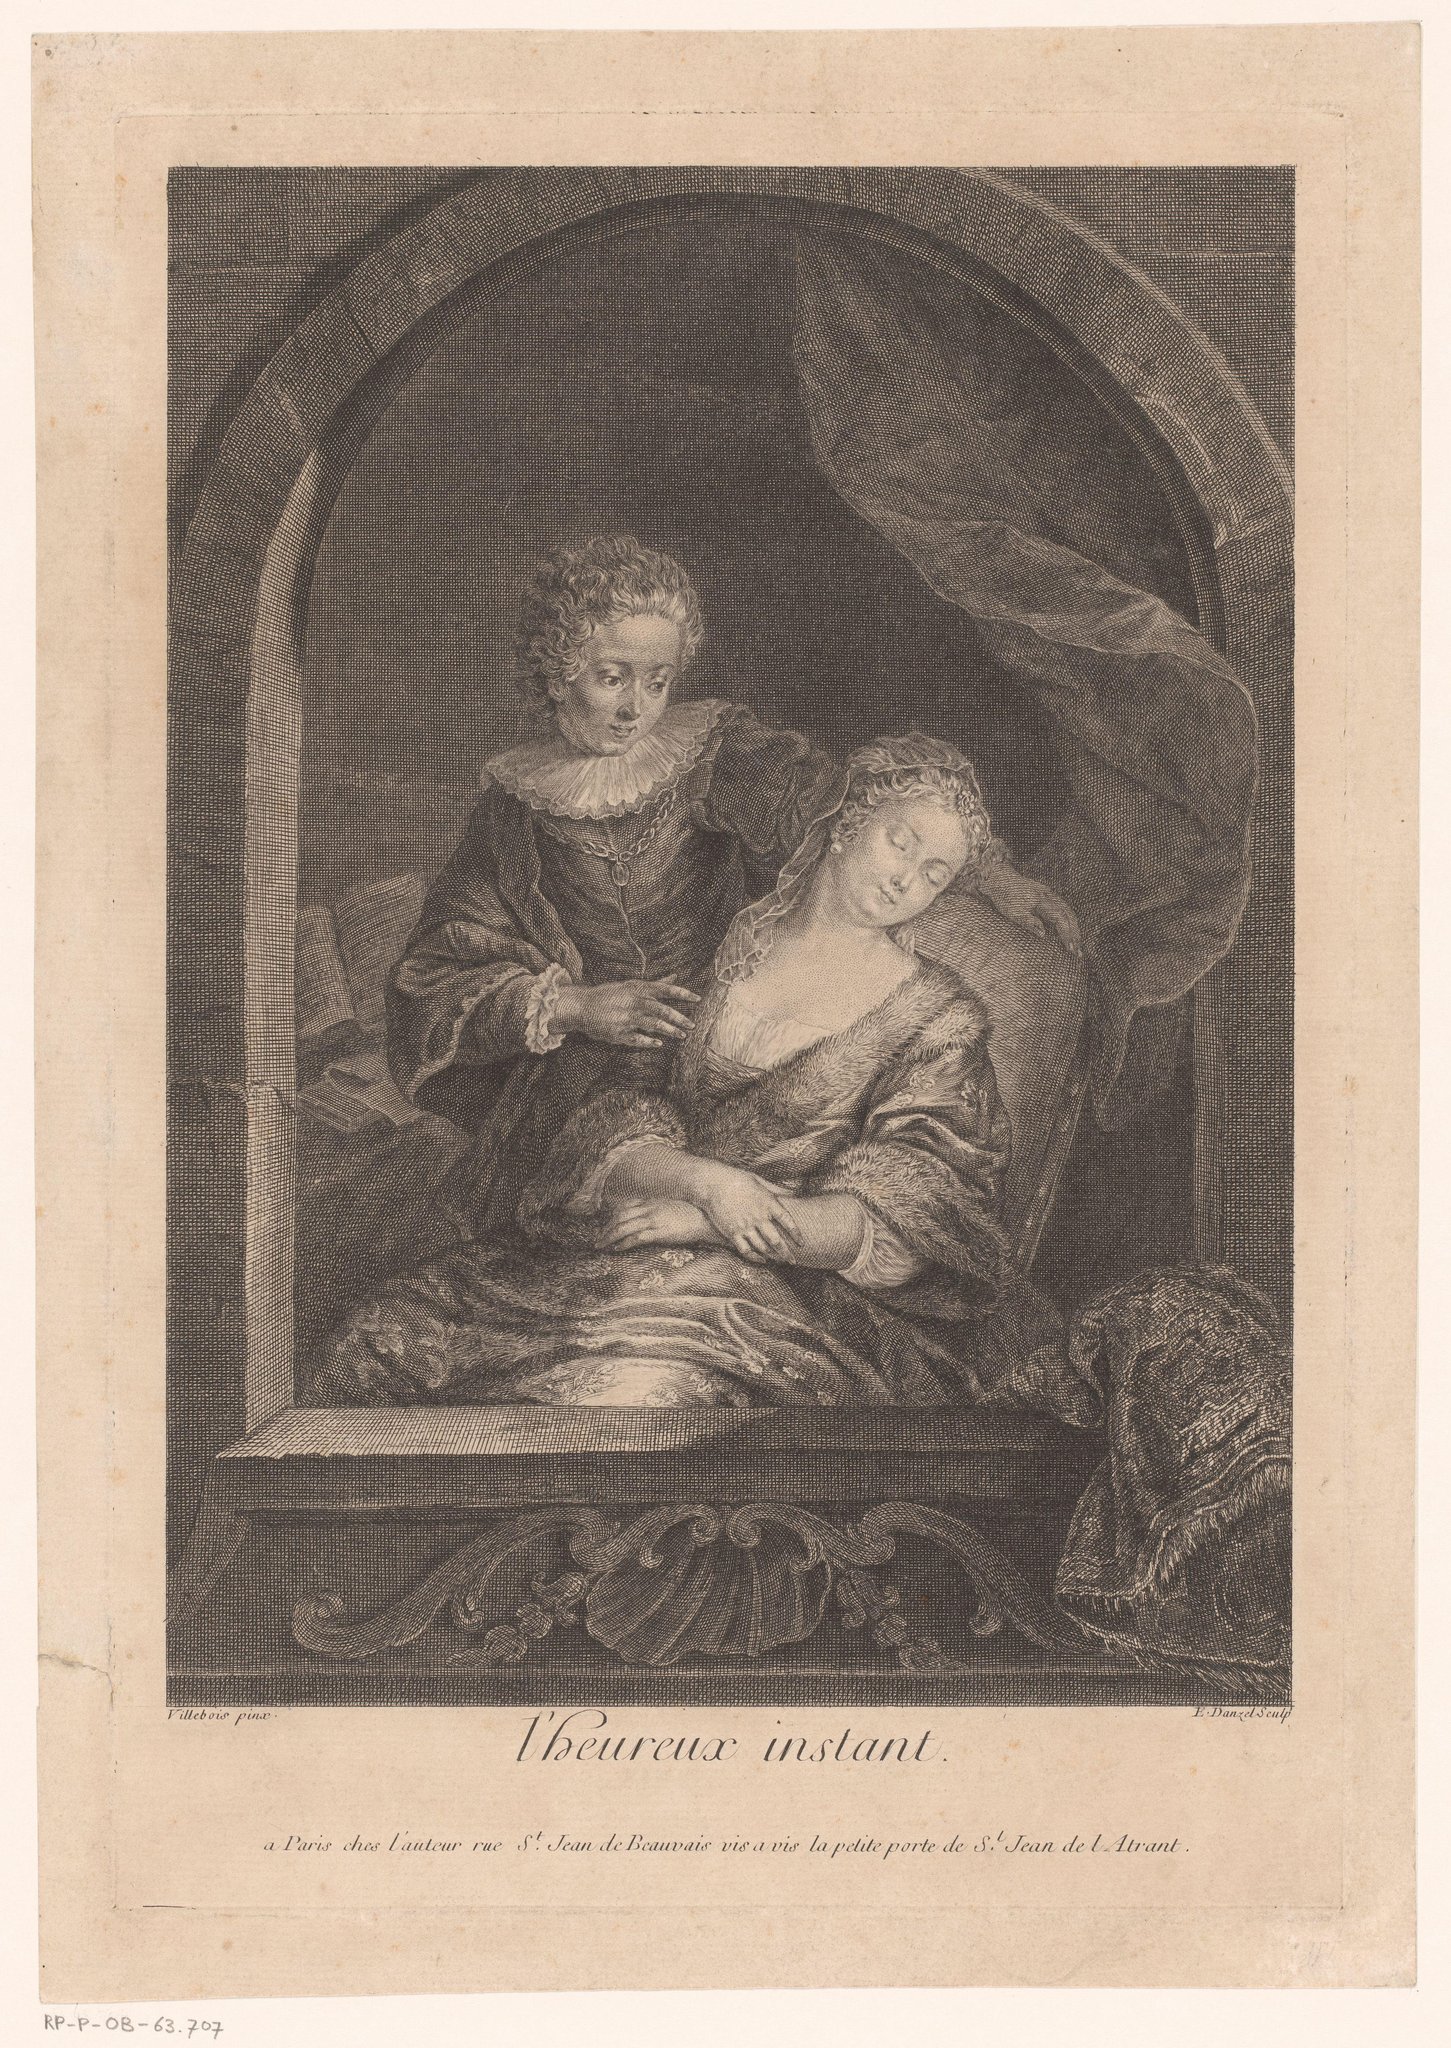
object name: print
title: Slapende jonge vrouw voor een venster met naast haar een jongen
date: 1745-1775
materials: paper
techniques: engraving, etching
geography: france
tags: adolescent, young woman, maiden, sleeping in chair, youth, adolescent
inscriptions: collector's mark: Lugt 2228